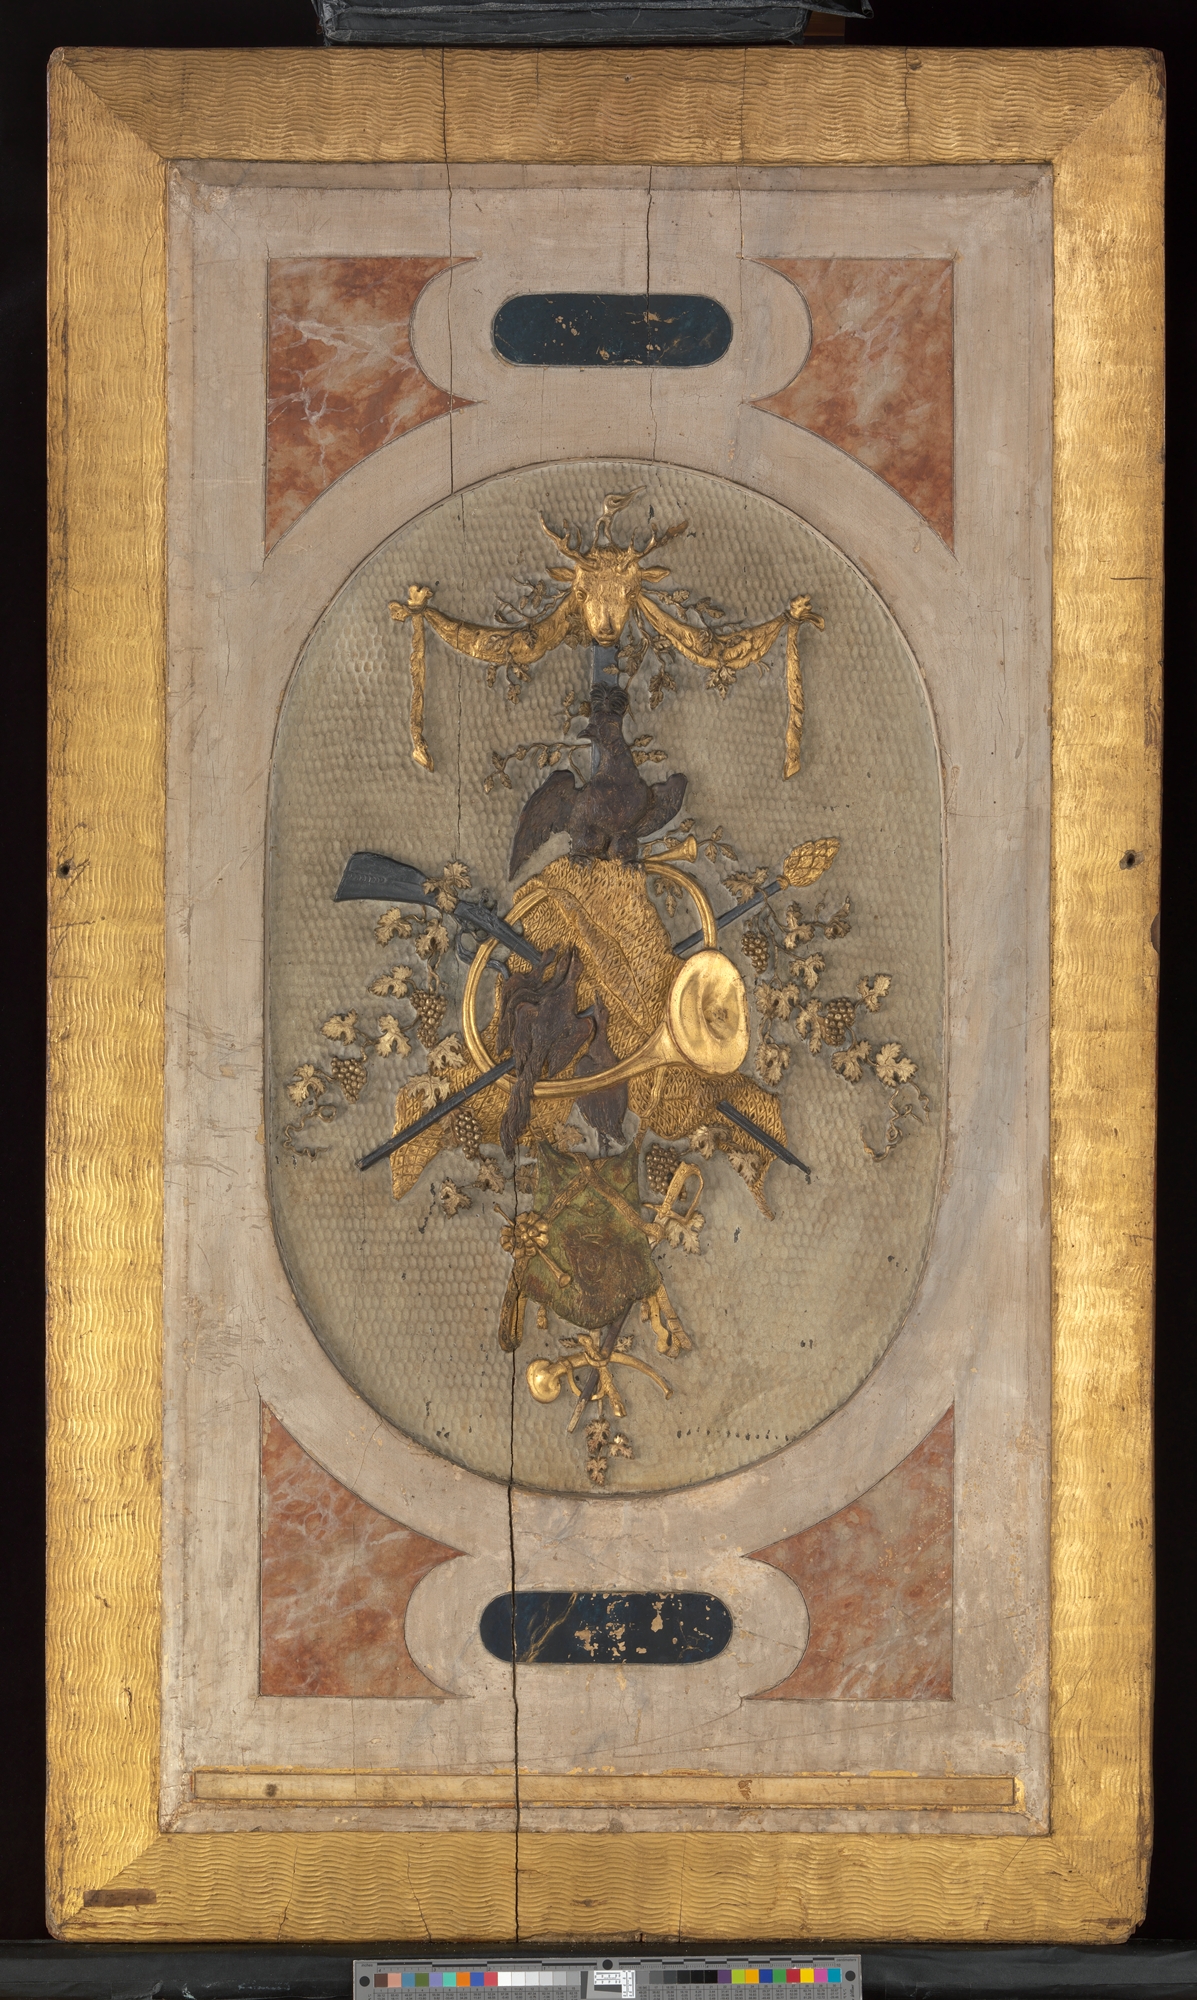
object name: panel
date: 1770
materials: wood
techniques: carving, gilding, painting, silvered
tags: birds,firearms